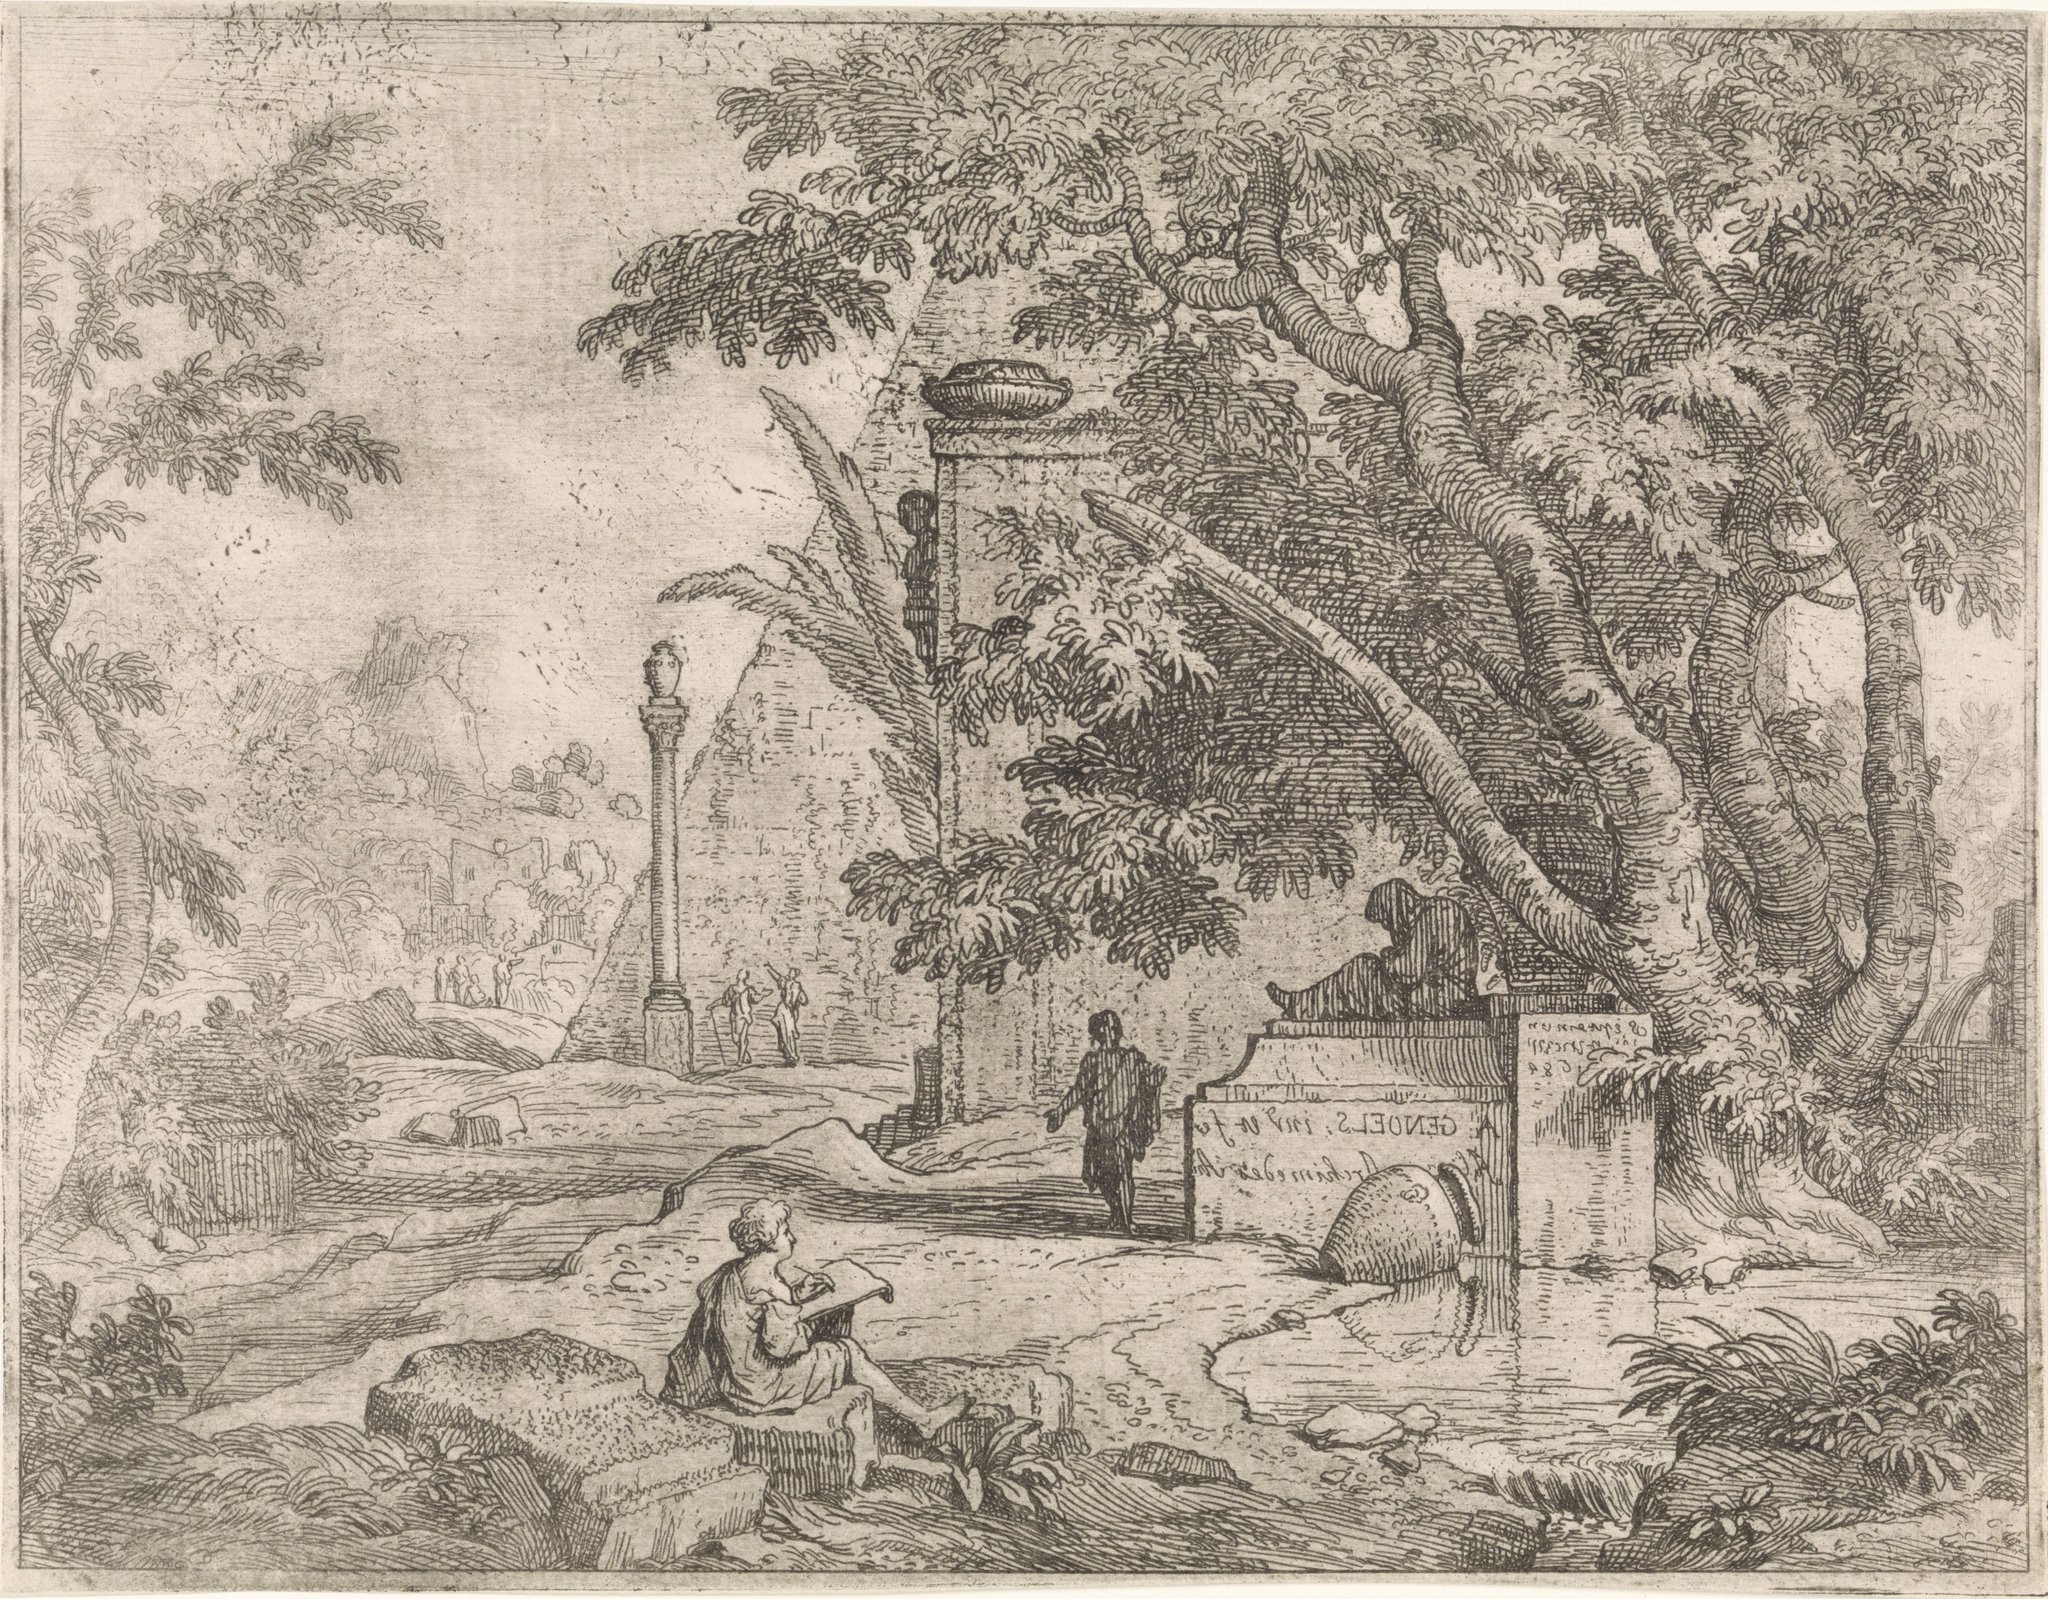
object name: print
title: Arcadisch landschap met ruïnes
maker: abraham genoels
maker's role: draughtsman, print maker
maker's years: 1640-1723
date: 1684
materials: paper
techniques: etching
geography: rome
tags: landscape with ruins, draughtsman at work - cc - out of doors, pastorals, arcadian scenes, draughtsman studying classical remains - cc - out of doors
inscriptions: collector's mark: Lugt 240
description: Arcadisch landschap met klassieke ruïnes. Op de voorgrond schetst een kunstenaar een van de ruïnes.